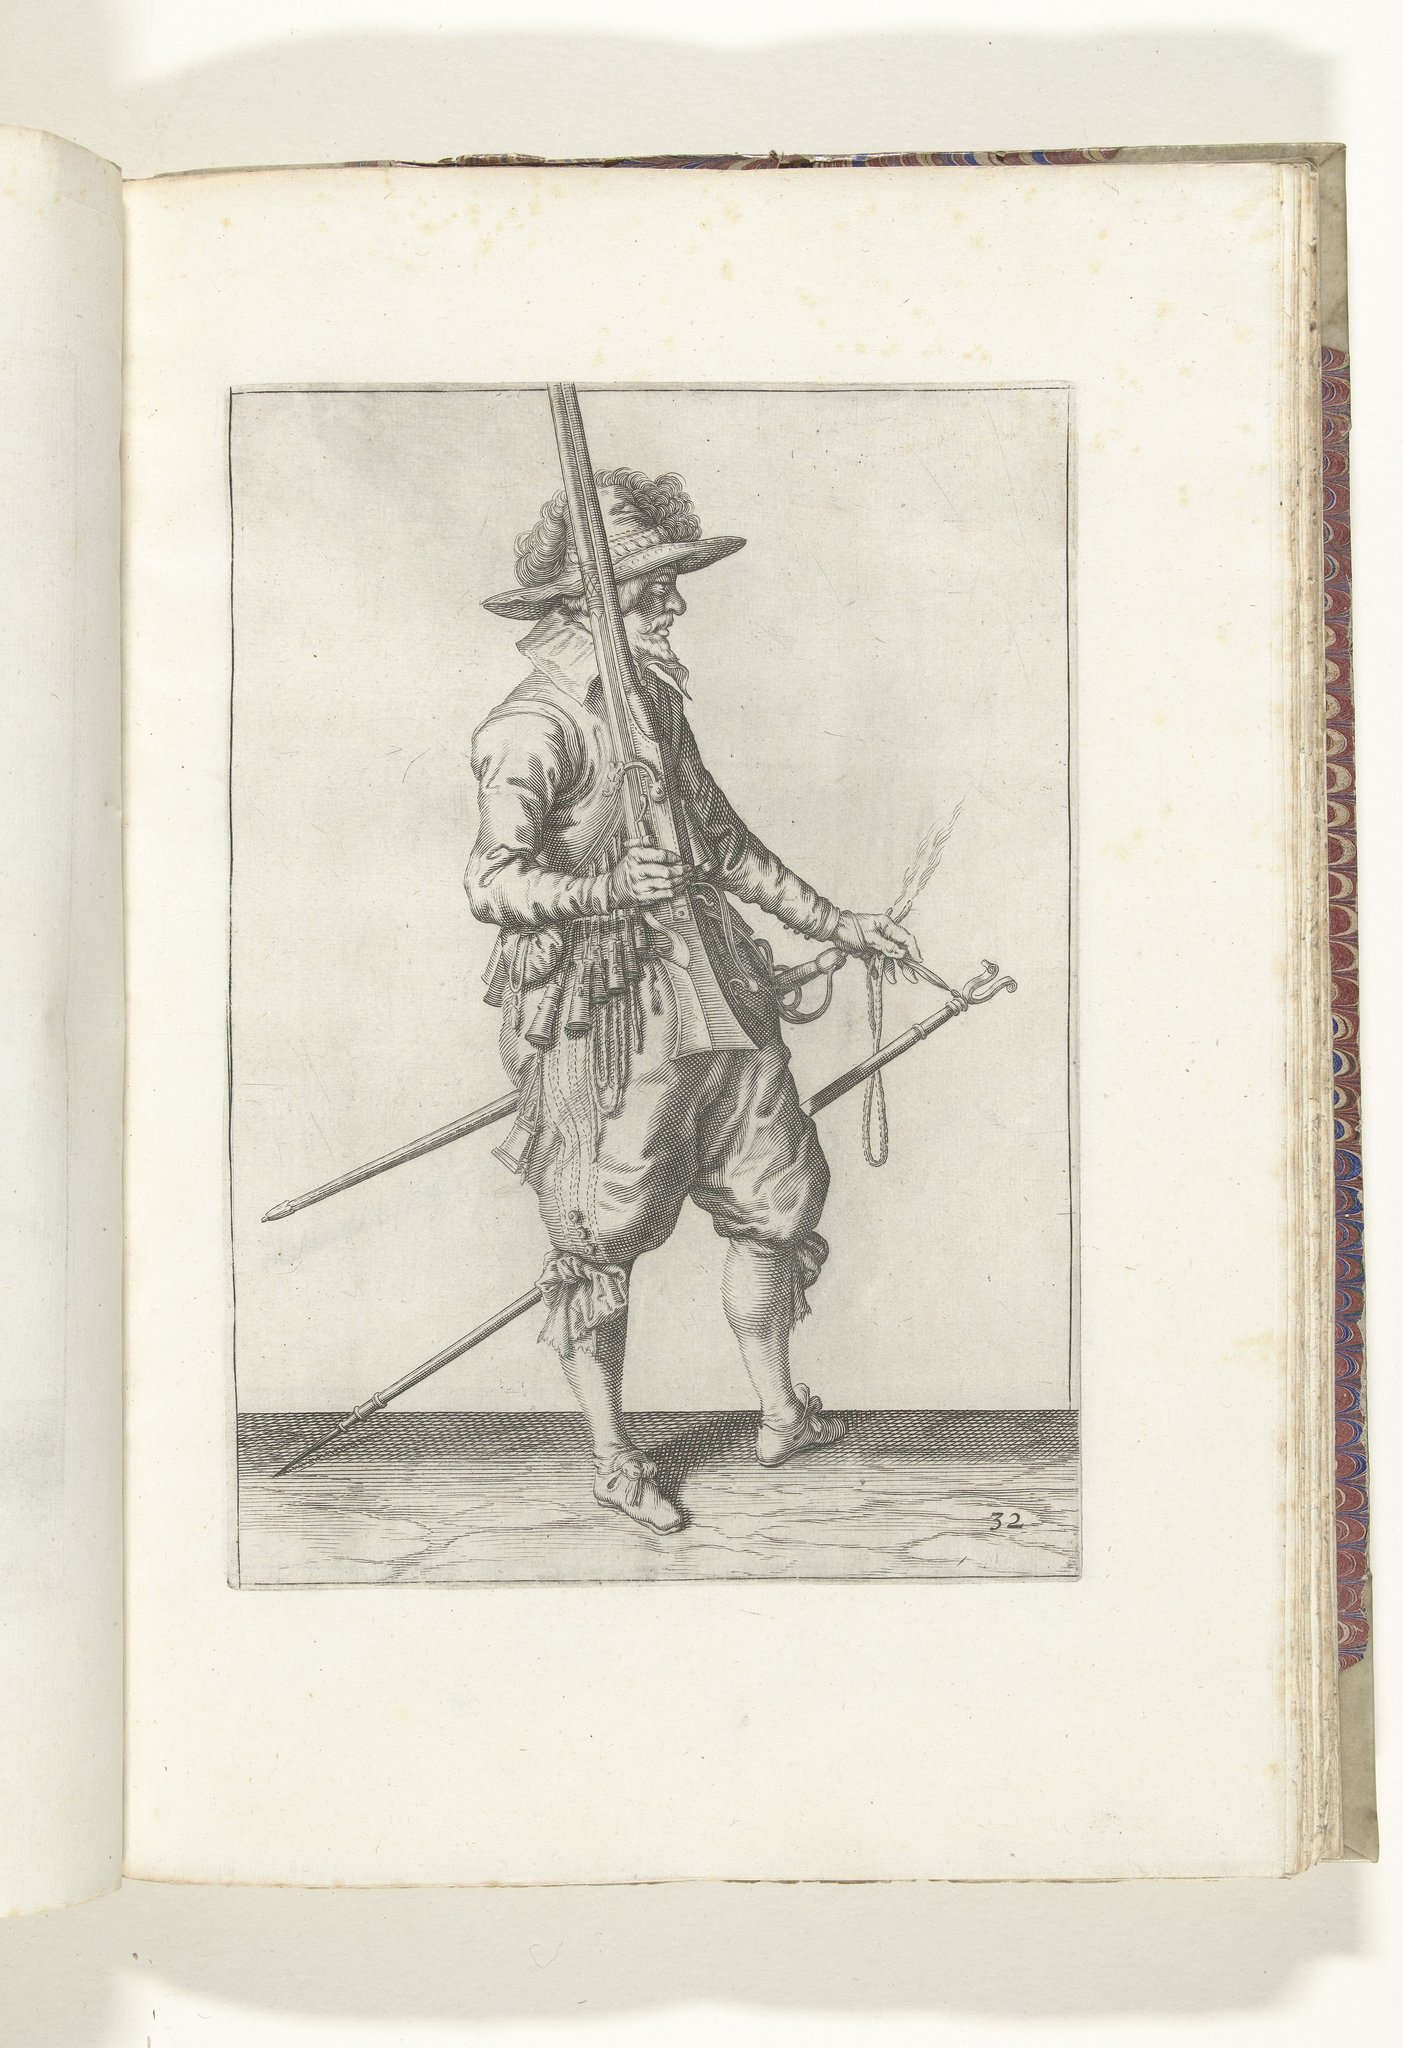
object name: print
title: Soldaat die zijn musket met zijn rechterhand rechtop vasthoudt (nr. 32), ca. 1600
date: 1597-1607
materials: paper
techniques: engraving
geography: northern netherlands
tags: maurice (prince of orange), handling of weapons ~ military training, weapons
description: Een soldaat, ten voeten uit, naar rechts, die een musket (een bepaald type vuurwapen) met zijn rechterhand vasthoudt, de loop omhoog wijzend, alvorens het wapen op zijn linkerschouder te leggen (nr. 32), ca. 1600. In zijn uitgestoken linkerhand een brandende lont; aan zijn linkerpols een furket (musketvork). Plaat 32 in de instructies voor het hanteren van het musket: Corte onderrechtinghe op de figuerlicke afbeeldinghe, soo veel aengaet het recht ghebruyck van Musquet. Onderdeel van de illustraties in: J. de Gheyn, Wapenhandelinghe van Roers Musquetten ende spiessen, Amsterdam, 1608. Krijgswezen rond 1600.